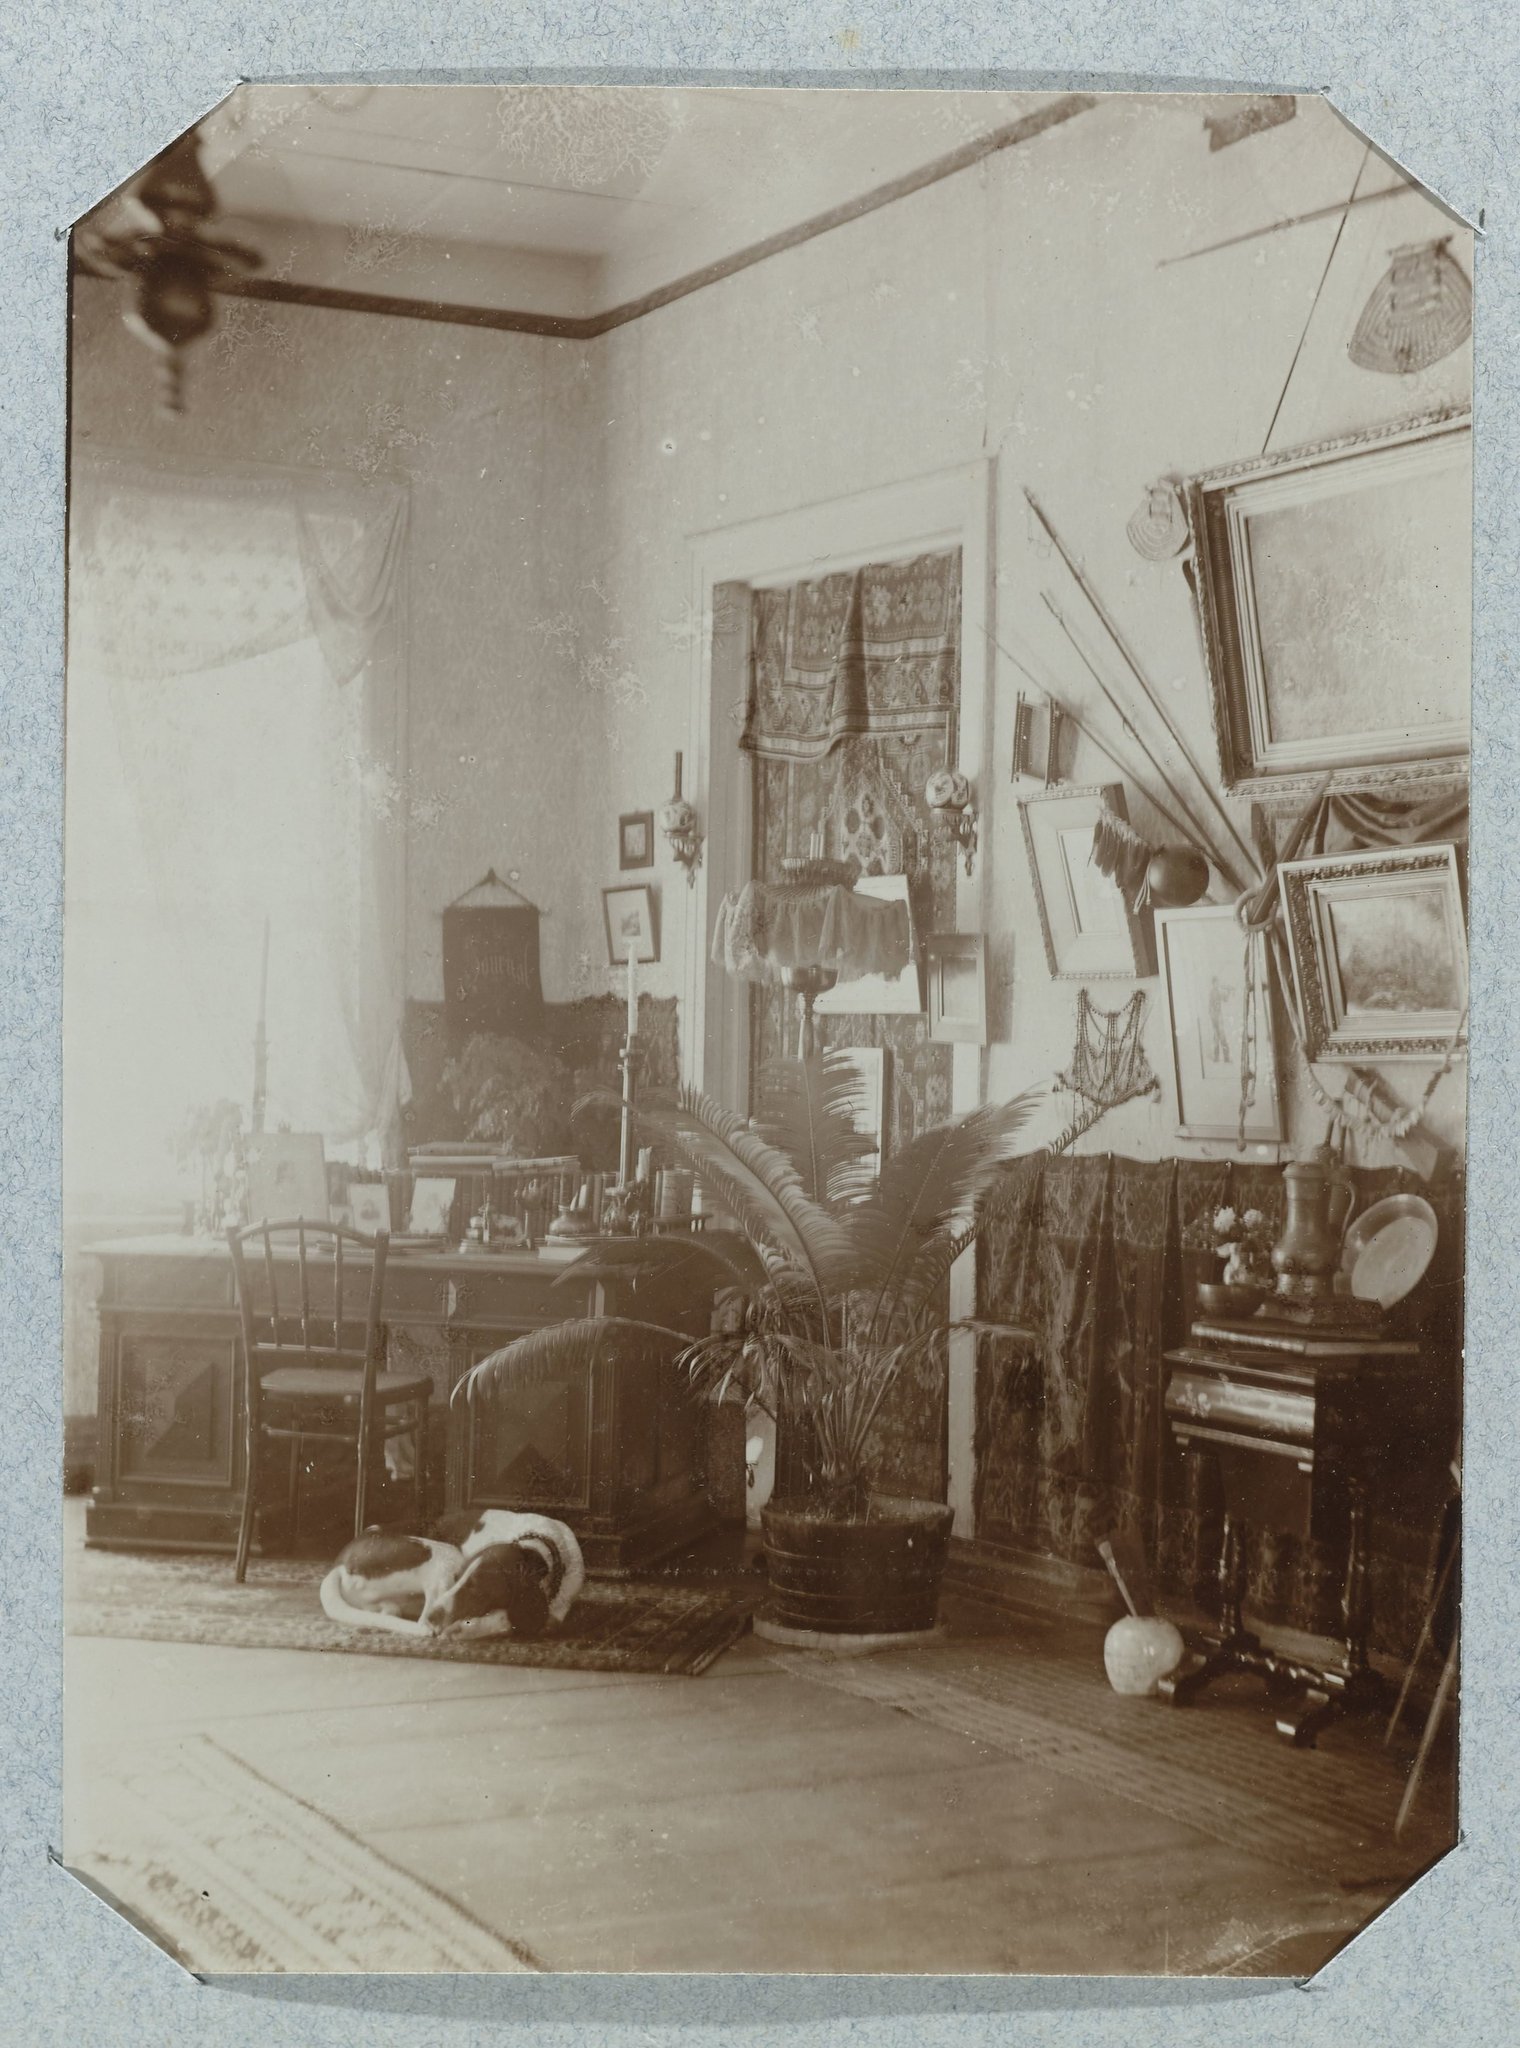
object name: photograph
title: Ons Intérieur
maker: théodore van lelyveld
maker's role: painter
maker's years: 1867-1954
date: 1895-1896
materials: photographic support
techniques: collodion silver print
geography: suriname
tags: communal rooms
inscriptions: inscription: ‘Ons Intérieur’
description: Interieur van het huis van het echtpaar Lelyveld aan de Gravenstraat te Paramaribo. Op een kleed voor het bureau ligt de hond Hector. Fotoafdruk in een fotoalbum van Théodore van Lelyveld over Suriname uit 1895-1898.